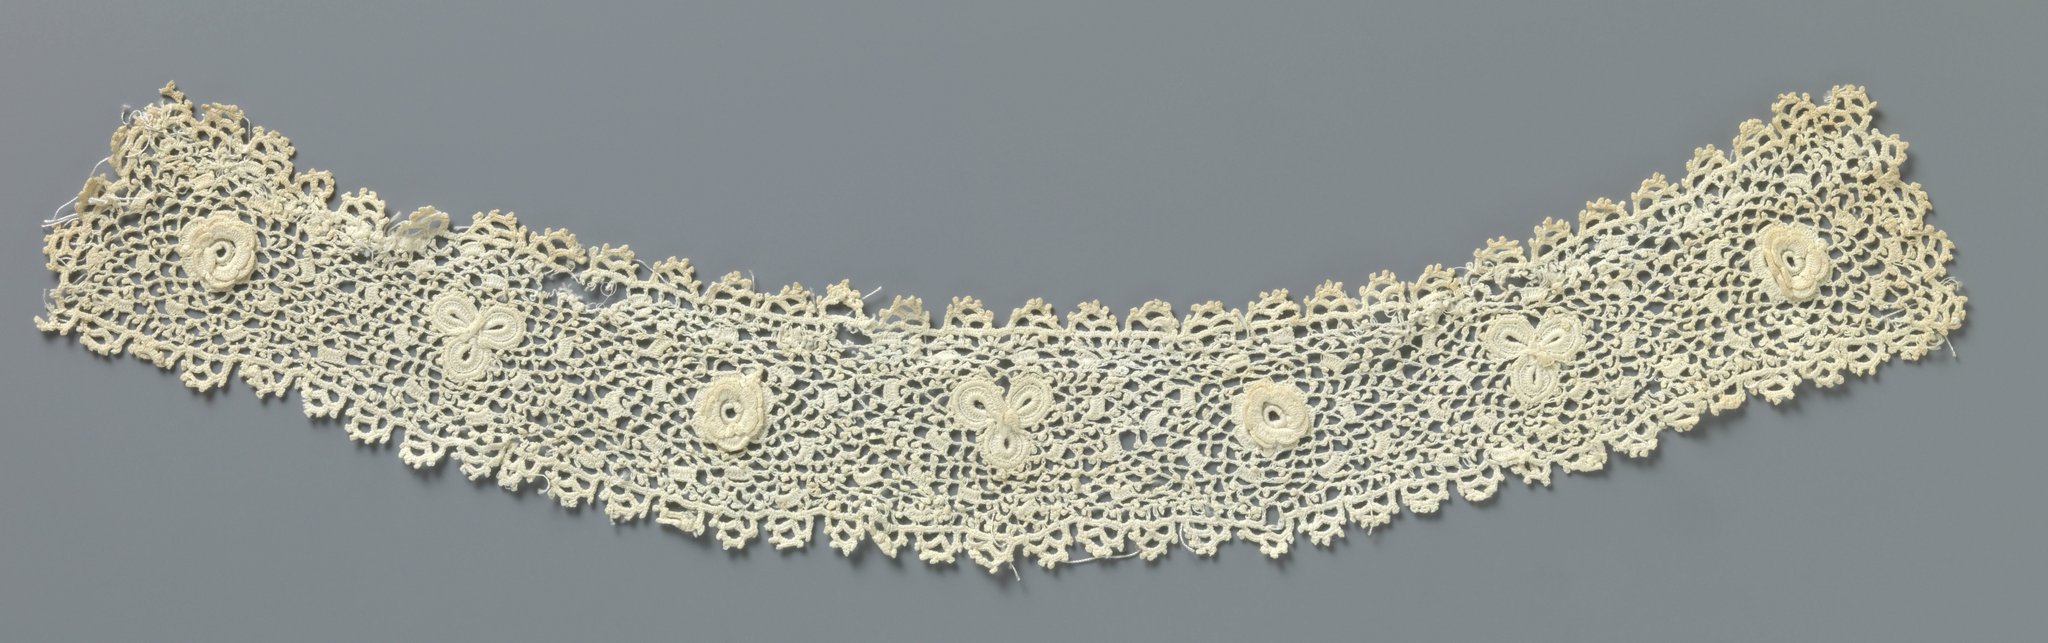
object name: strip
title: Strook gehaakte kant met roosje en klaverblad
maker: Anonymous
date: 1890-1909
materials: cotton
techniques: crocheted lace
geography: ireland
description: Het is een aanname dat deze Ierse gehaakte kant ook daadwerkelijk in Ierland is gemaakt. Ierse gehaakte kant kent zijn oorsprong rond 1760 en kwam vanaf 1840 in ontwikkeling. Aangezien volgens Martine Bruggeman (Kant in Europa) de Ierse haakindustrie aan het eind van de 19e eeuw gereorganiseerd werd en in populariteit groeide, is het hier beschreven stuk gedateerd rond 1890, tot 1909 vanwege de datering in het eerste decennium van populariteit van Ierse gehaakte kant volgens het Kantlexicon (Johan Coene).